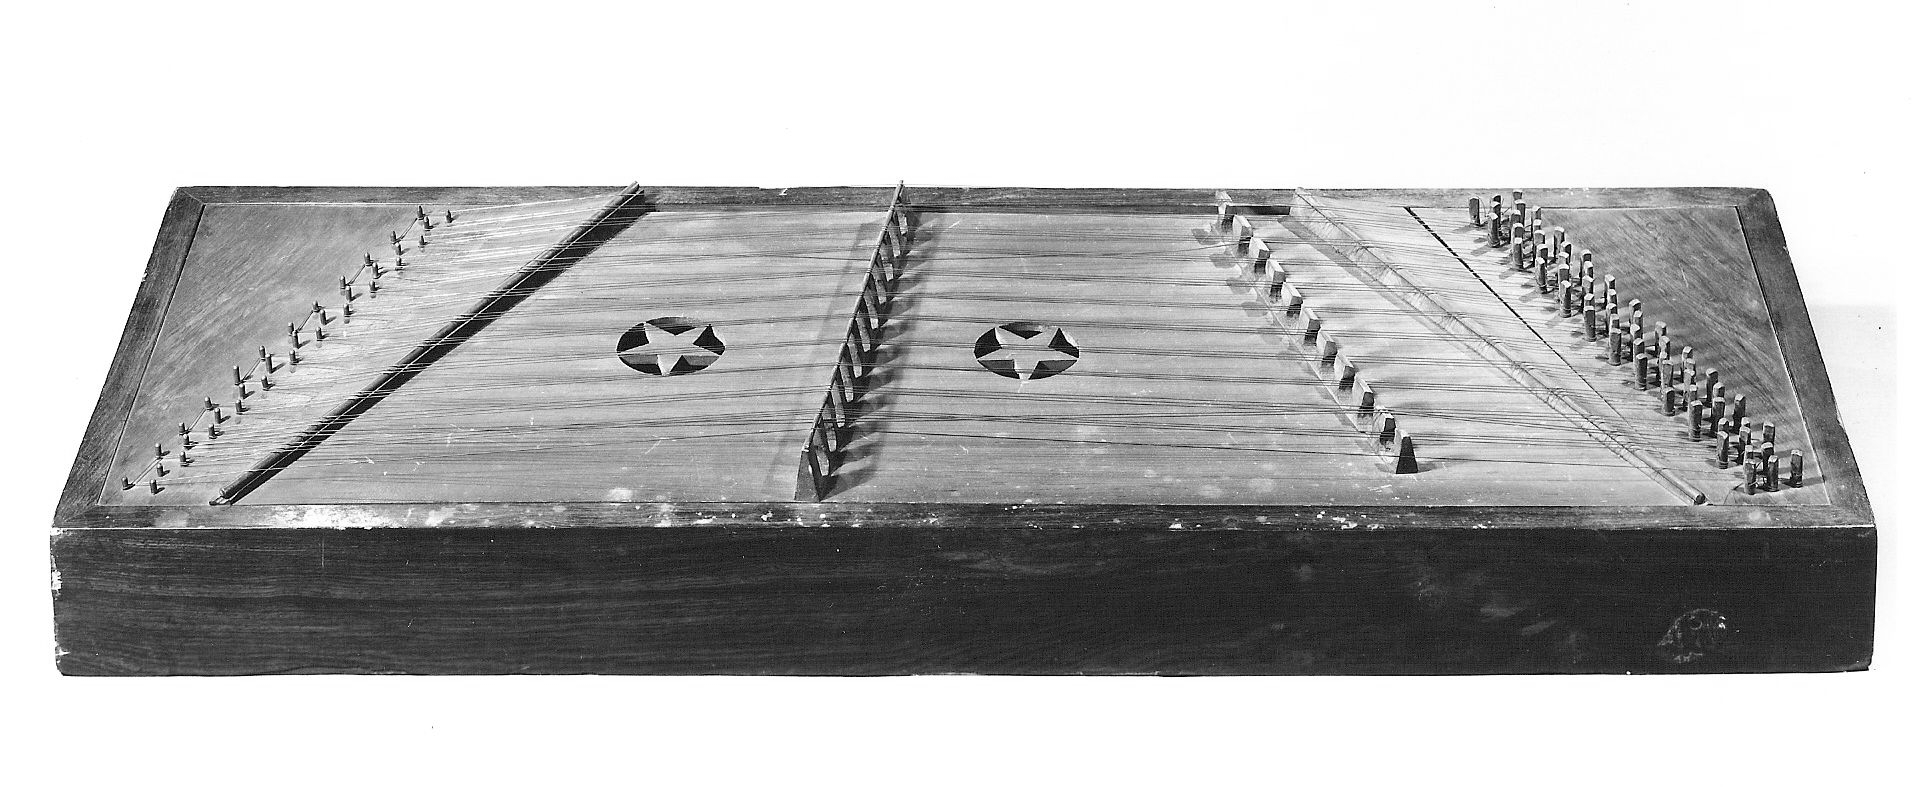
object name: hammered dulcimer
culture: american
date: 1834-1866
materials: metal, wood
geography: united states